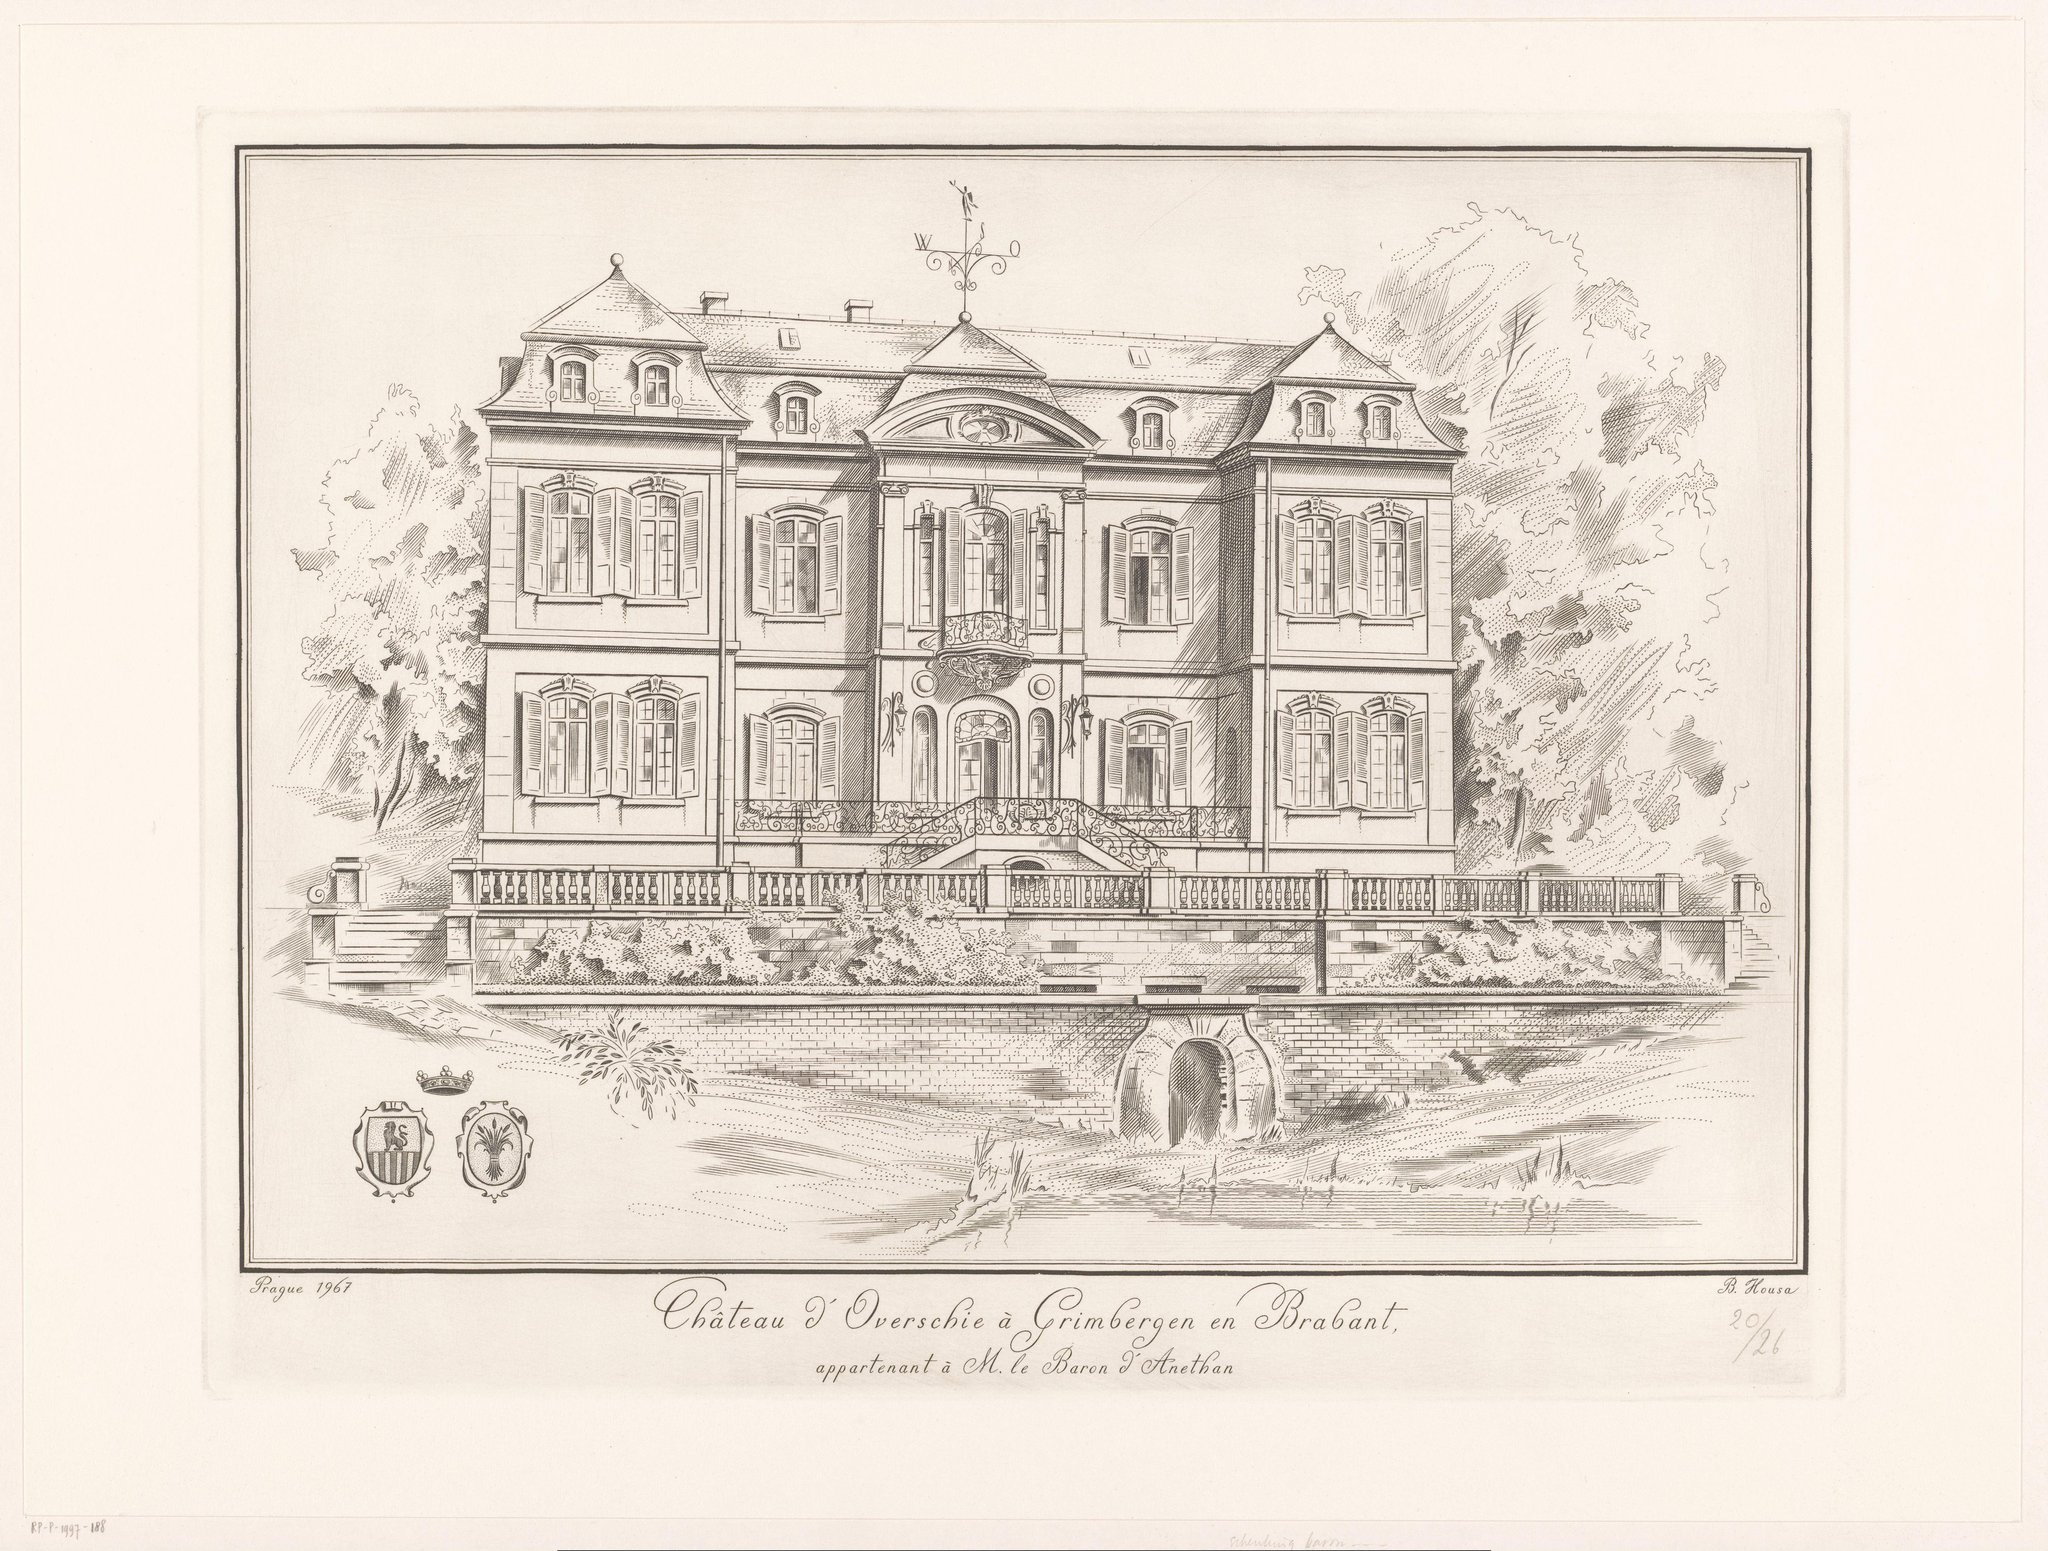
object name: print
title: Chateau d'Overschie a Grimbergen en Brabant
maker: b. housa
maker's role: print maker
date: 1967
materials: paper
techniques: etching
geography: prague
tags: castle, landscape with tower or castle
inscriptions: edition: ‘20/26’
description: Linksonder de wapens van Baron d'Anethan, aan wie het kasteel in 1967 behoorde.